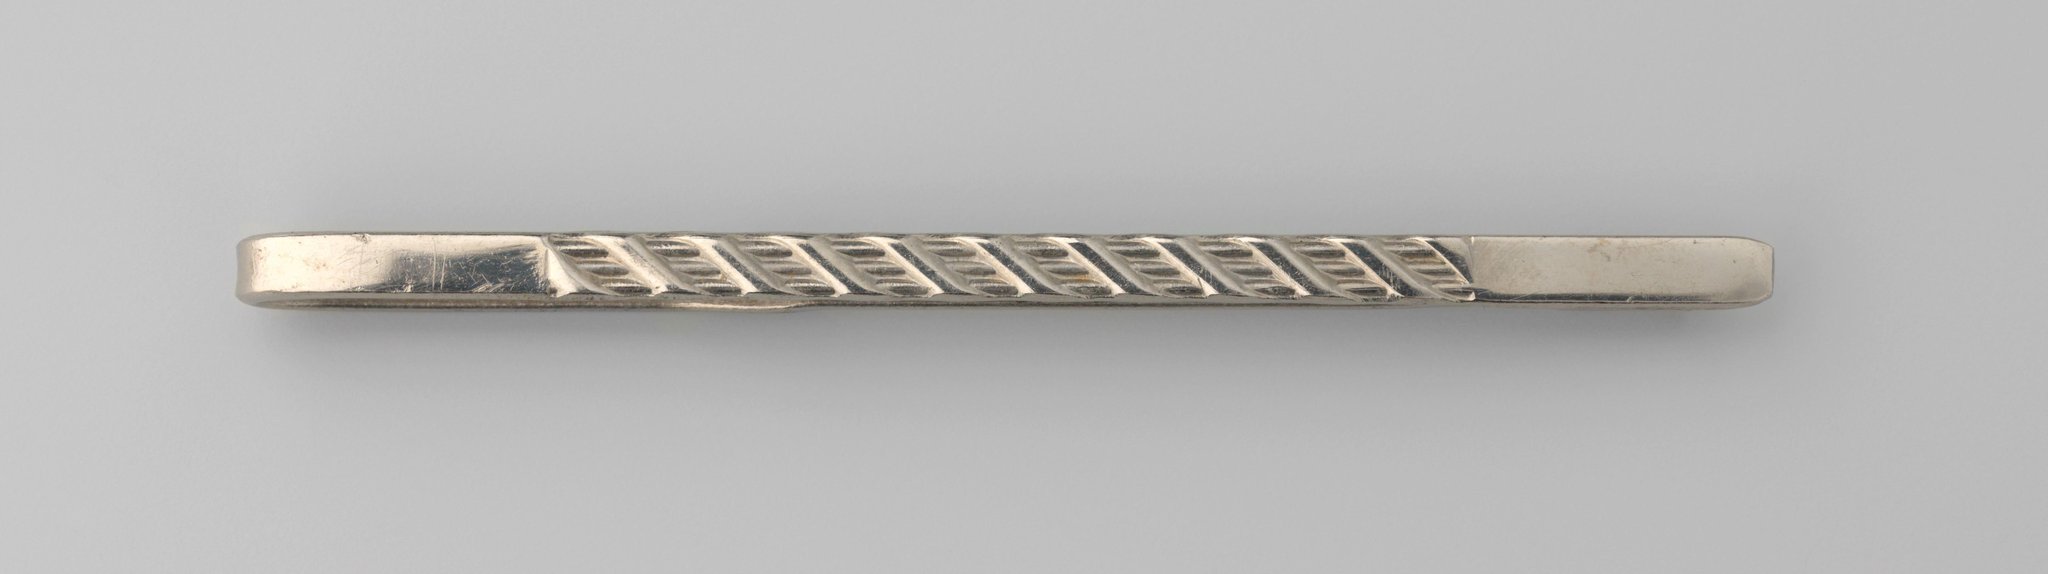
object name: fragment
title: Helft van een doorgezaagde dasspeld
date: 1998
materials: metal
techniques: sawing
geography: netherlands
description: Helft van een doorgezaagde dasspeld in draadwerk; de andere helft van de dasspeld is verwerkt in een hanger samengesteld uit doorgezaagde sieraden aan koordketting van zilver. De doorgezaagde sieraden zijn afkomstig van de moeder van Marjan Unger.